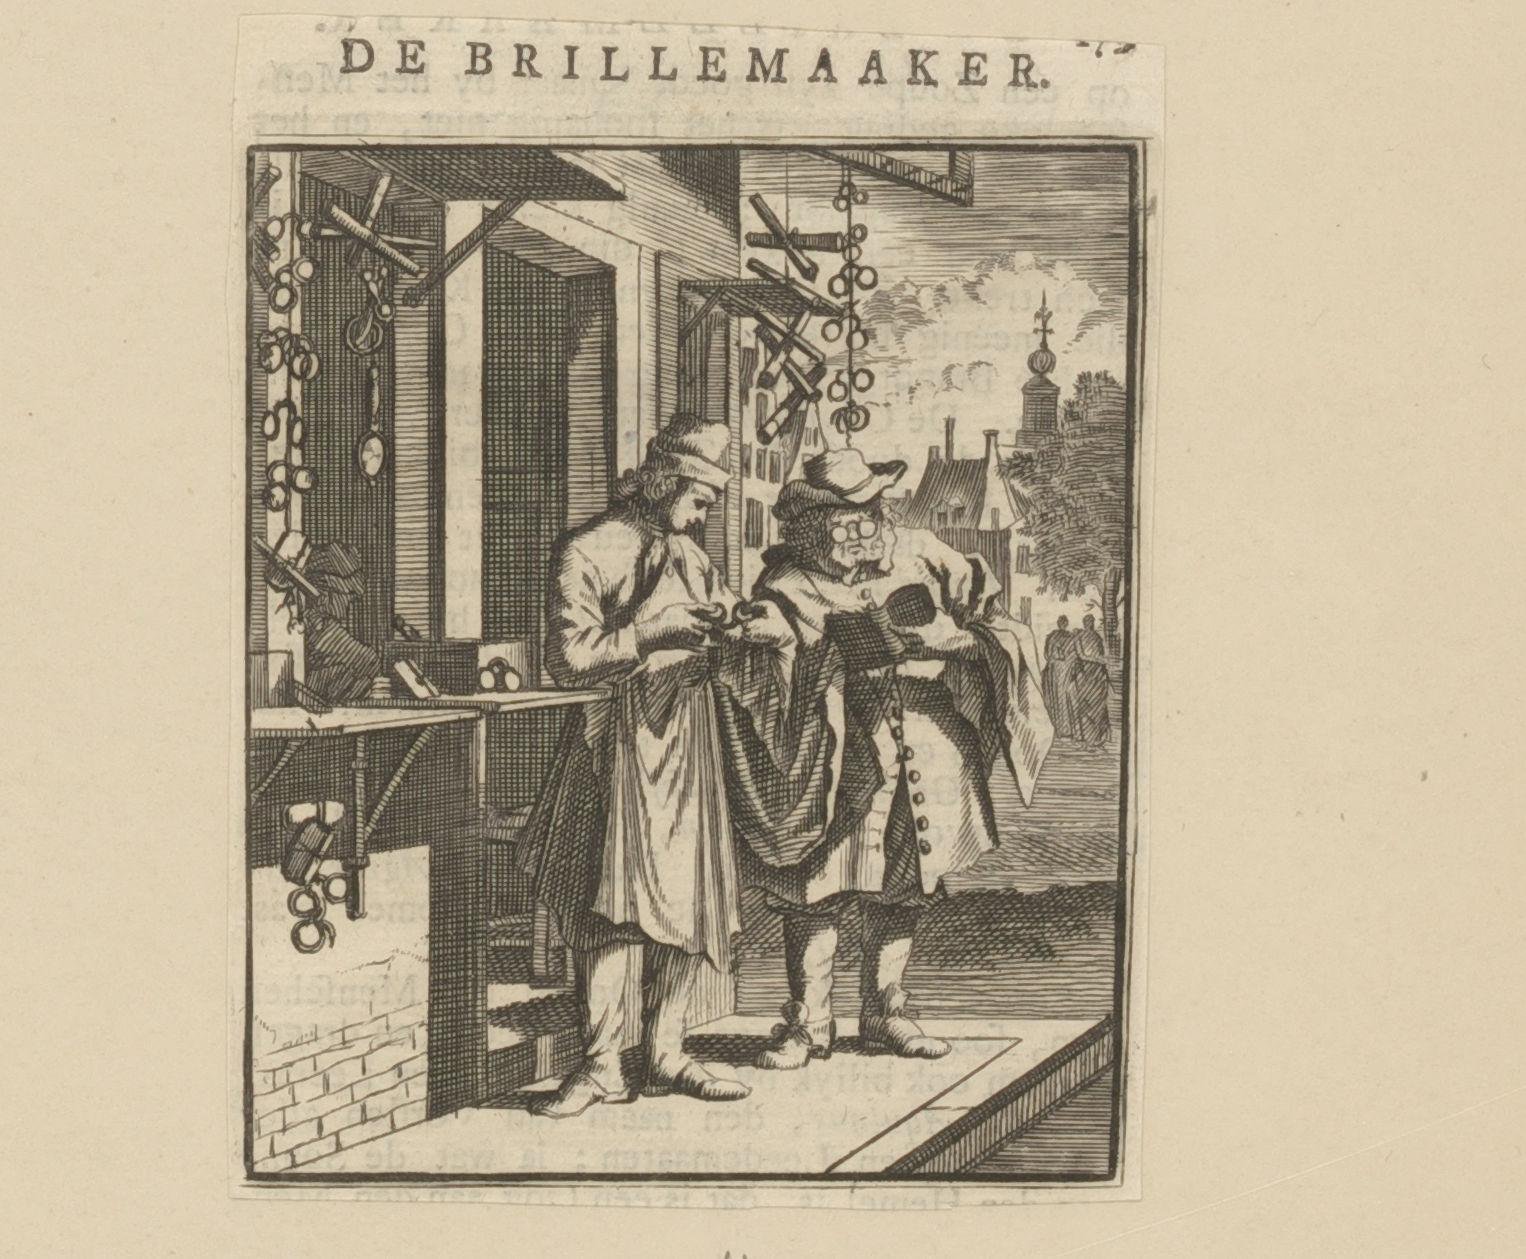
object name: print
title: Twee mannen voor een brillenzaak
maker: Anonymous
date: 1719-1759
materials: paper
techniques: etching, letterpress printing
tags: eyeglasses, spectacles, handicrafts, craftsman at work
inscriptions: stamp, collector's mark: Lugt 1641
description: Prent met andere letterzetting gebruikt in: St. Clara, Abraham van. Iets voor allen. [Vertaald door] J. le Long. Amsterdam: Janssoons van Waesberge, 1719, dl. 2. En in: St. Clara, Abraham van. Iets voor allen. [Vertaald door] J. le Long. Amsterdam: Jan Roman de Jonge, 1741, dl. 2. En in: St. Clara, Abraham van. Iets voor allen. [Vertaald door] J. le Long. Amsterdam: Jan Roman, 1759, dl. 2. Huidige prent uit een andere editie. Naar een prent van: Jan Luyken.